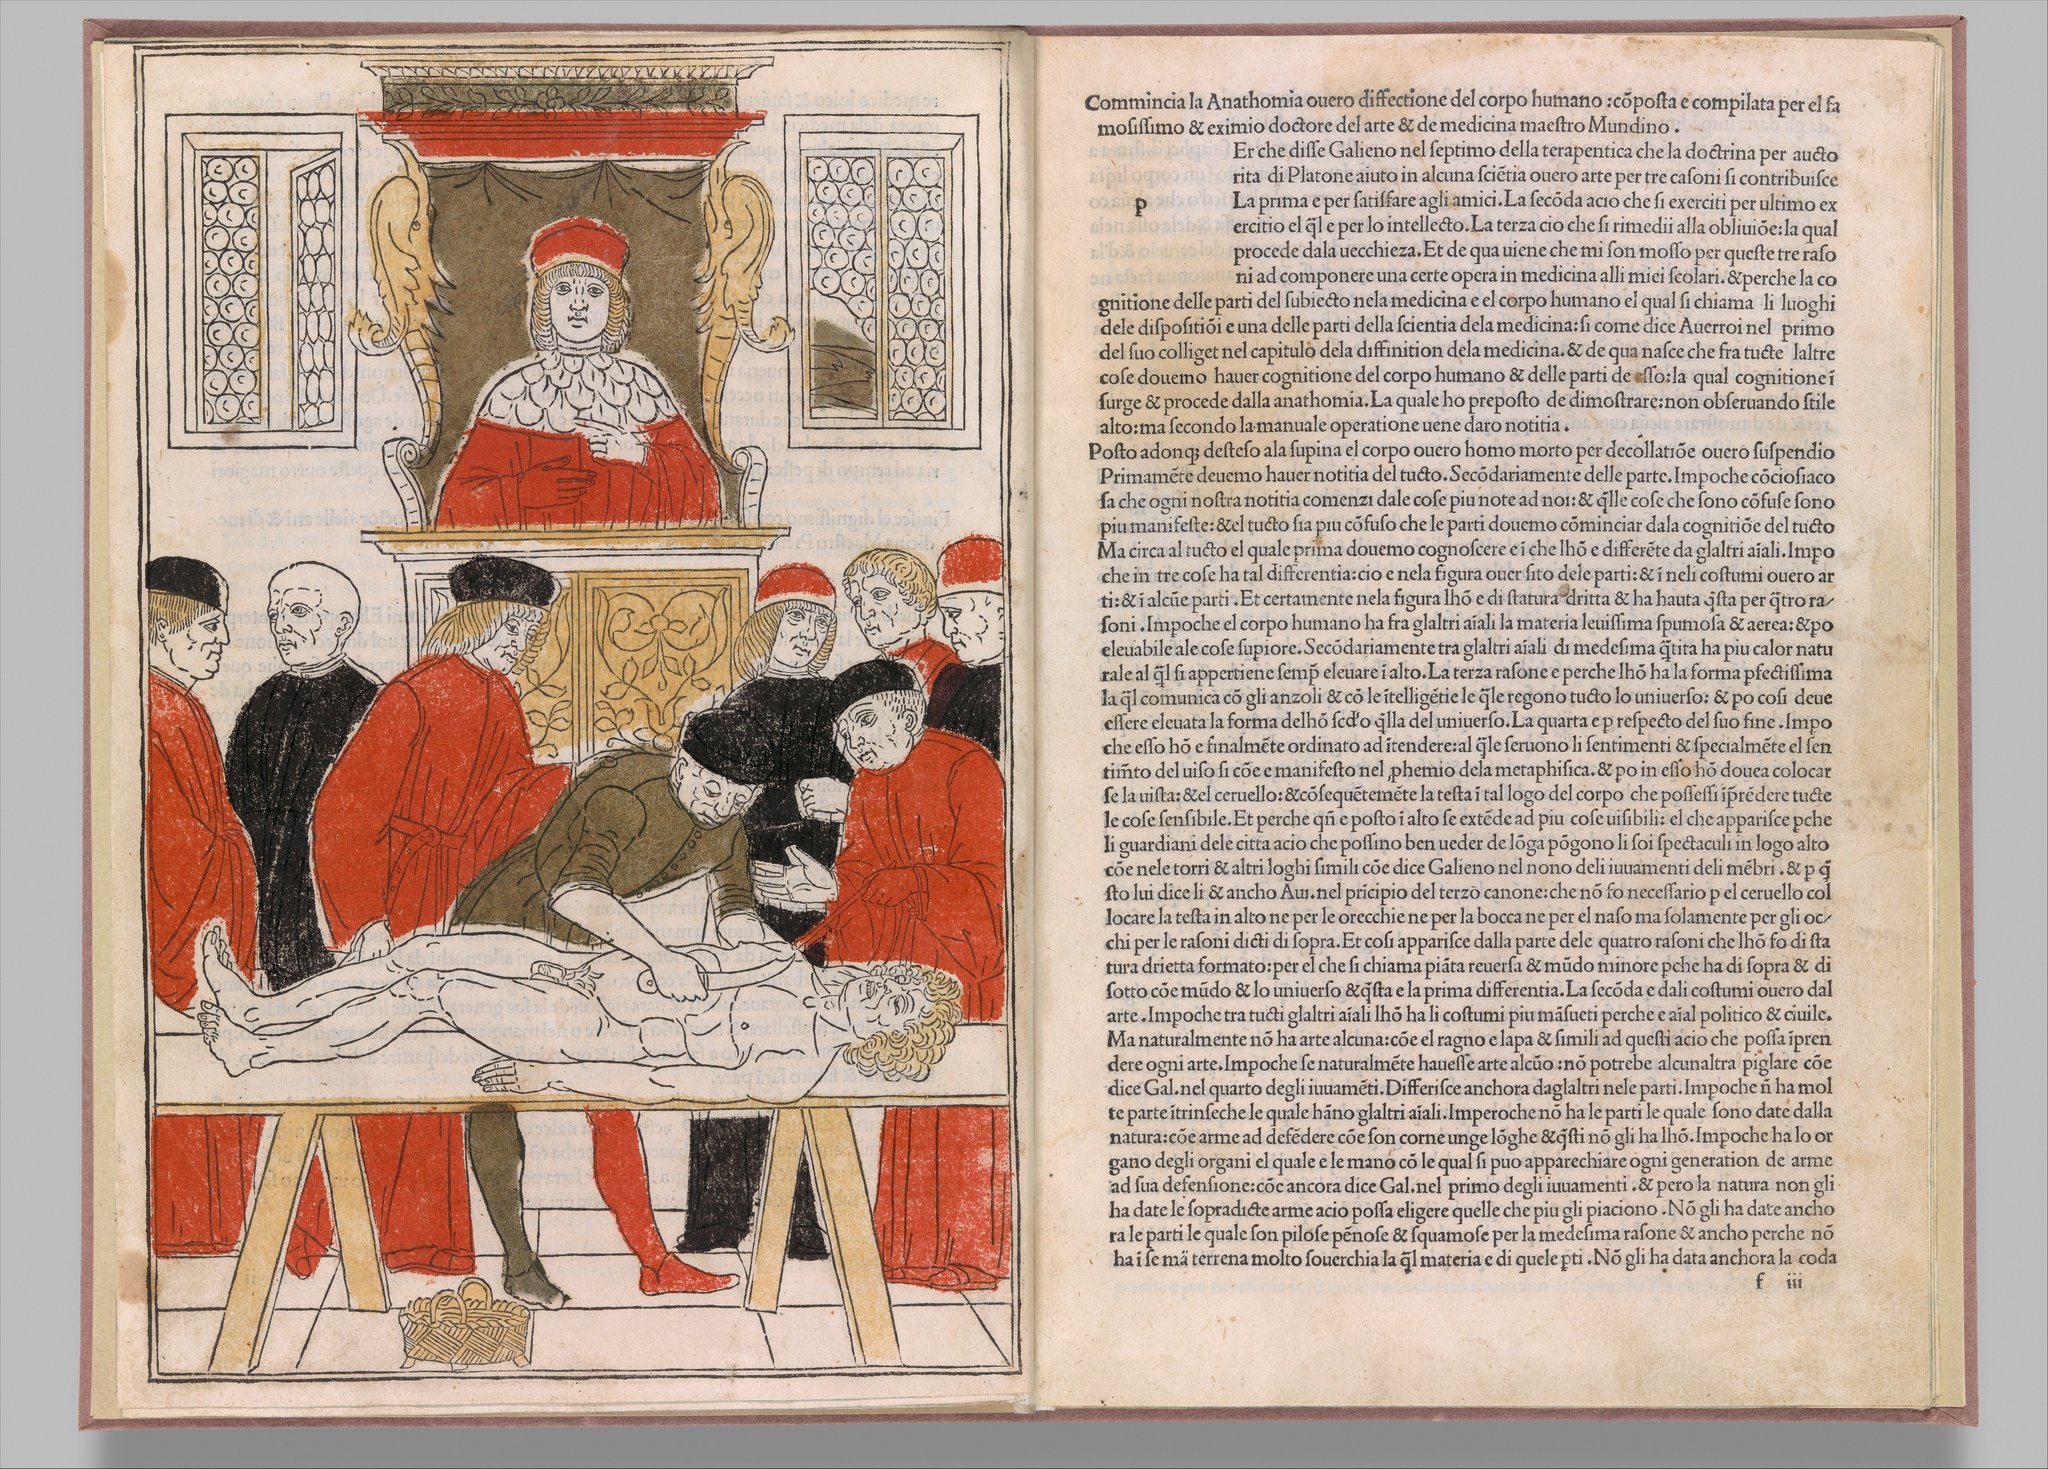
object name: book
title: Fasciculo di medicina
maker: johannes de ketham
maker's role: editor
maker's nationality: german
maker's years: 1400-1550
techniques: woodcut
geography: italy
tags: human anatomy,science,men,male nudes,medicine